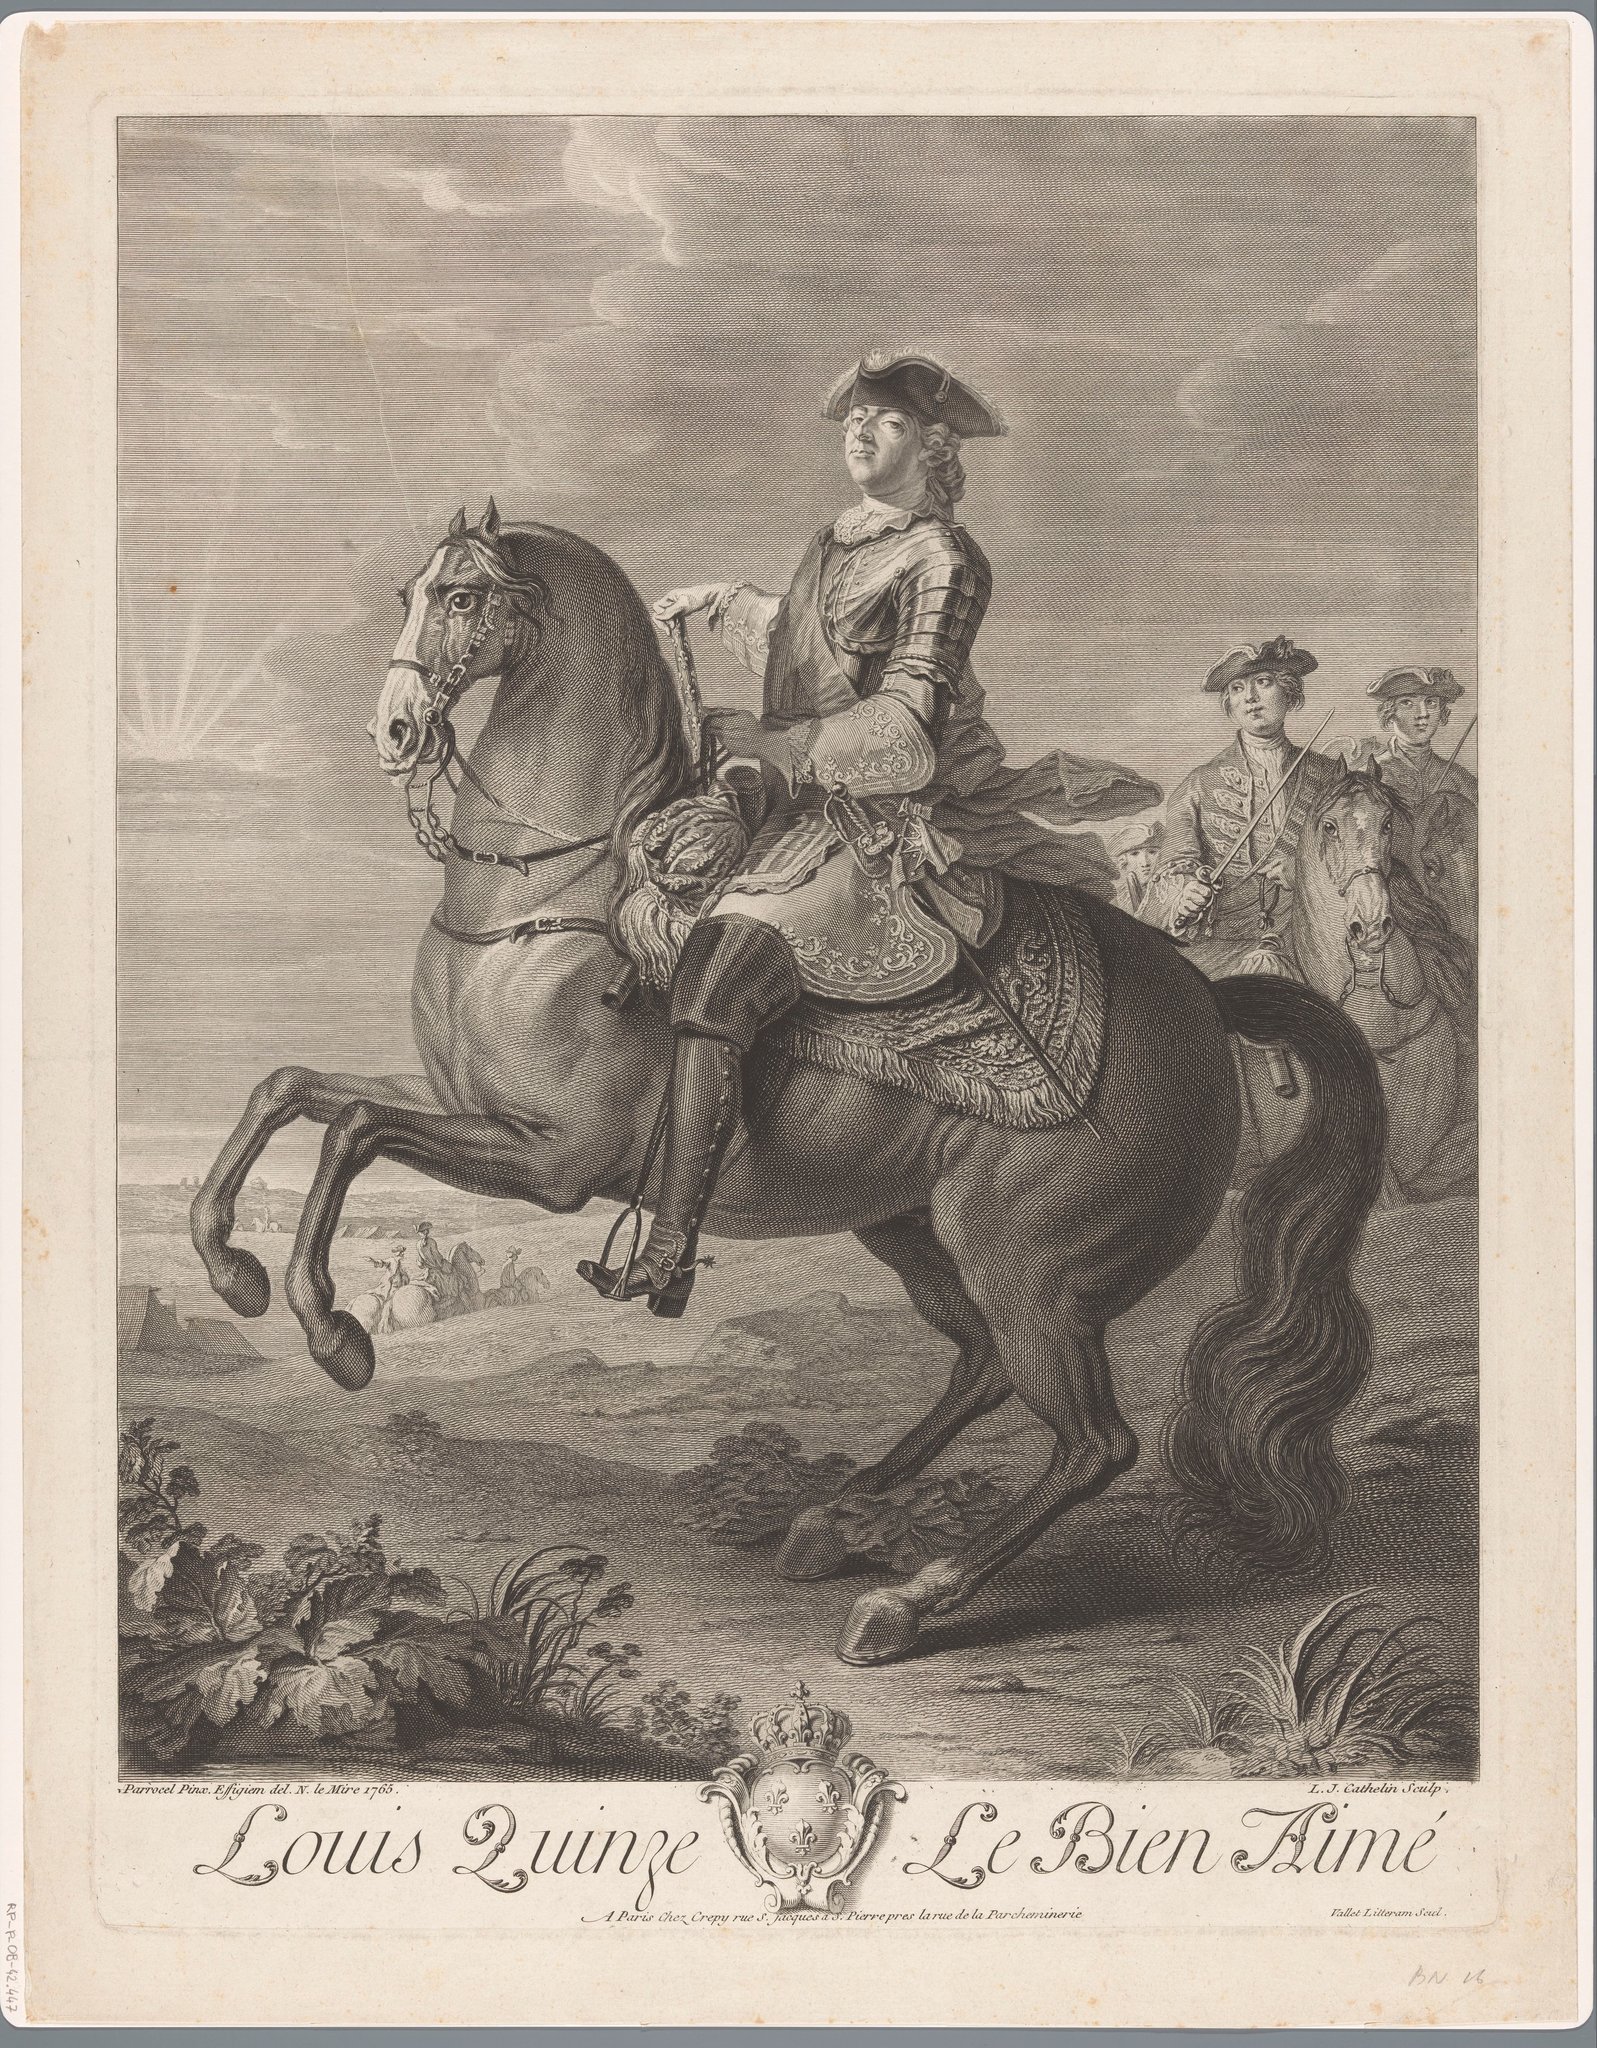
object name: print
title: Louis Quinze le Bien Aimé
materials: paper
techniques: engraving, etching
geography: france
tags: louis xv of france, historical persons, equestrian statue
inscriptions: collector's mark: Lugt 240